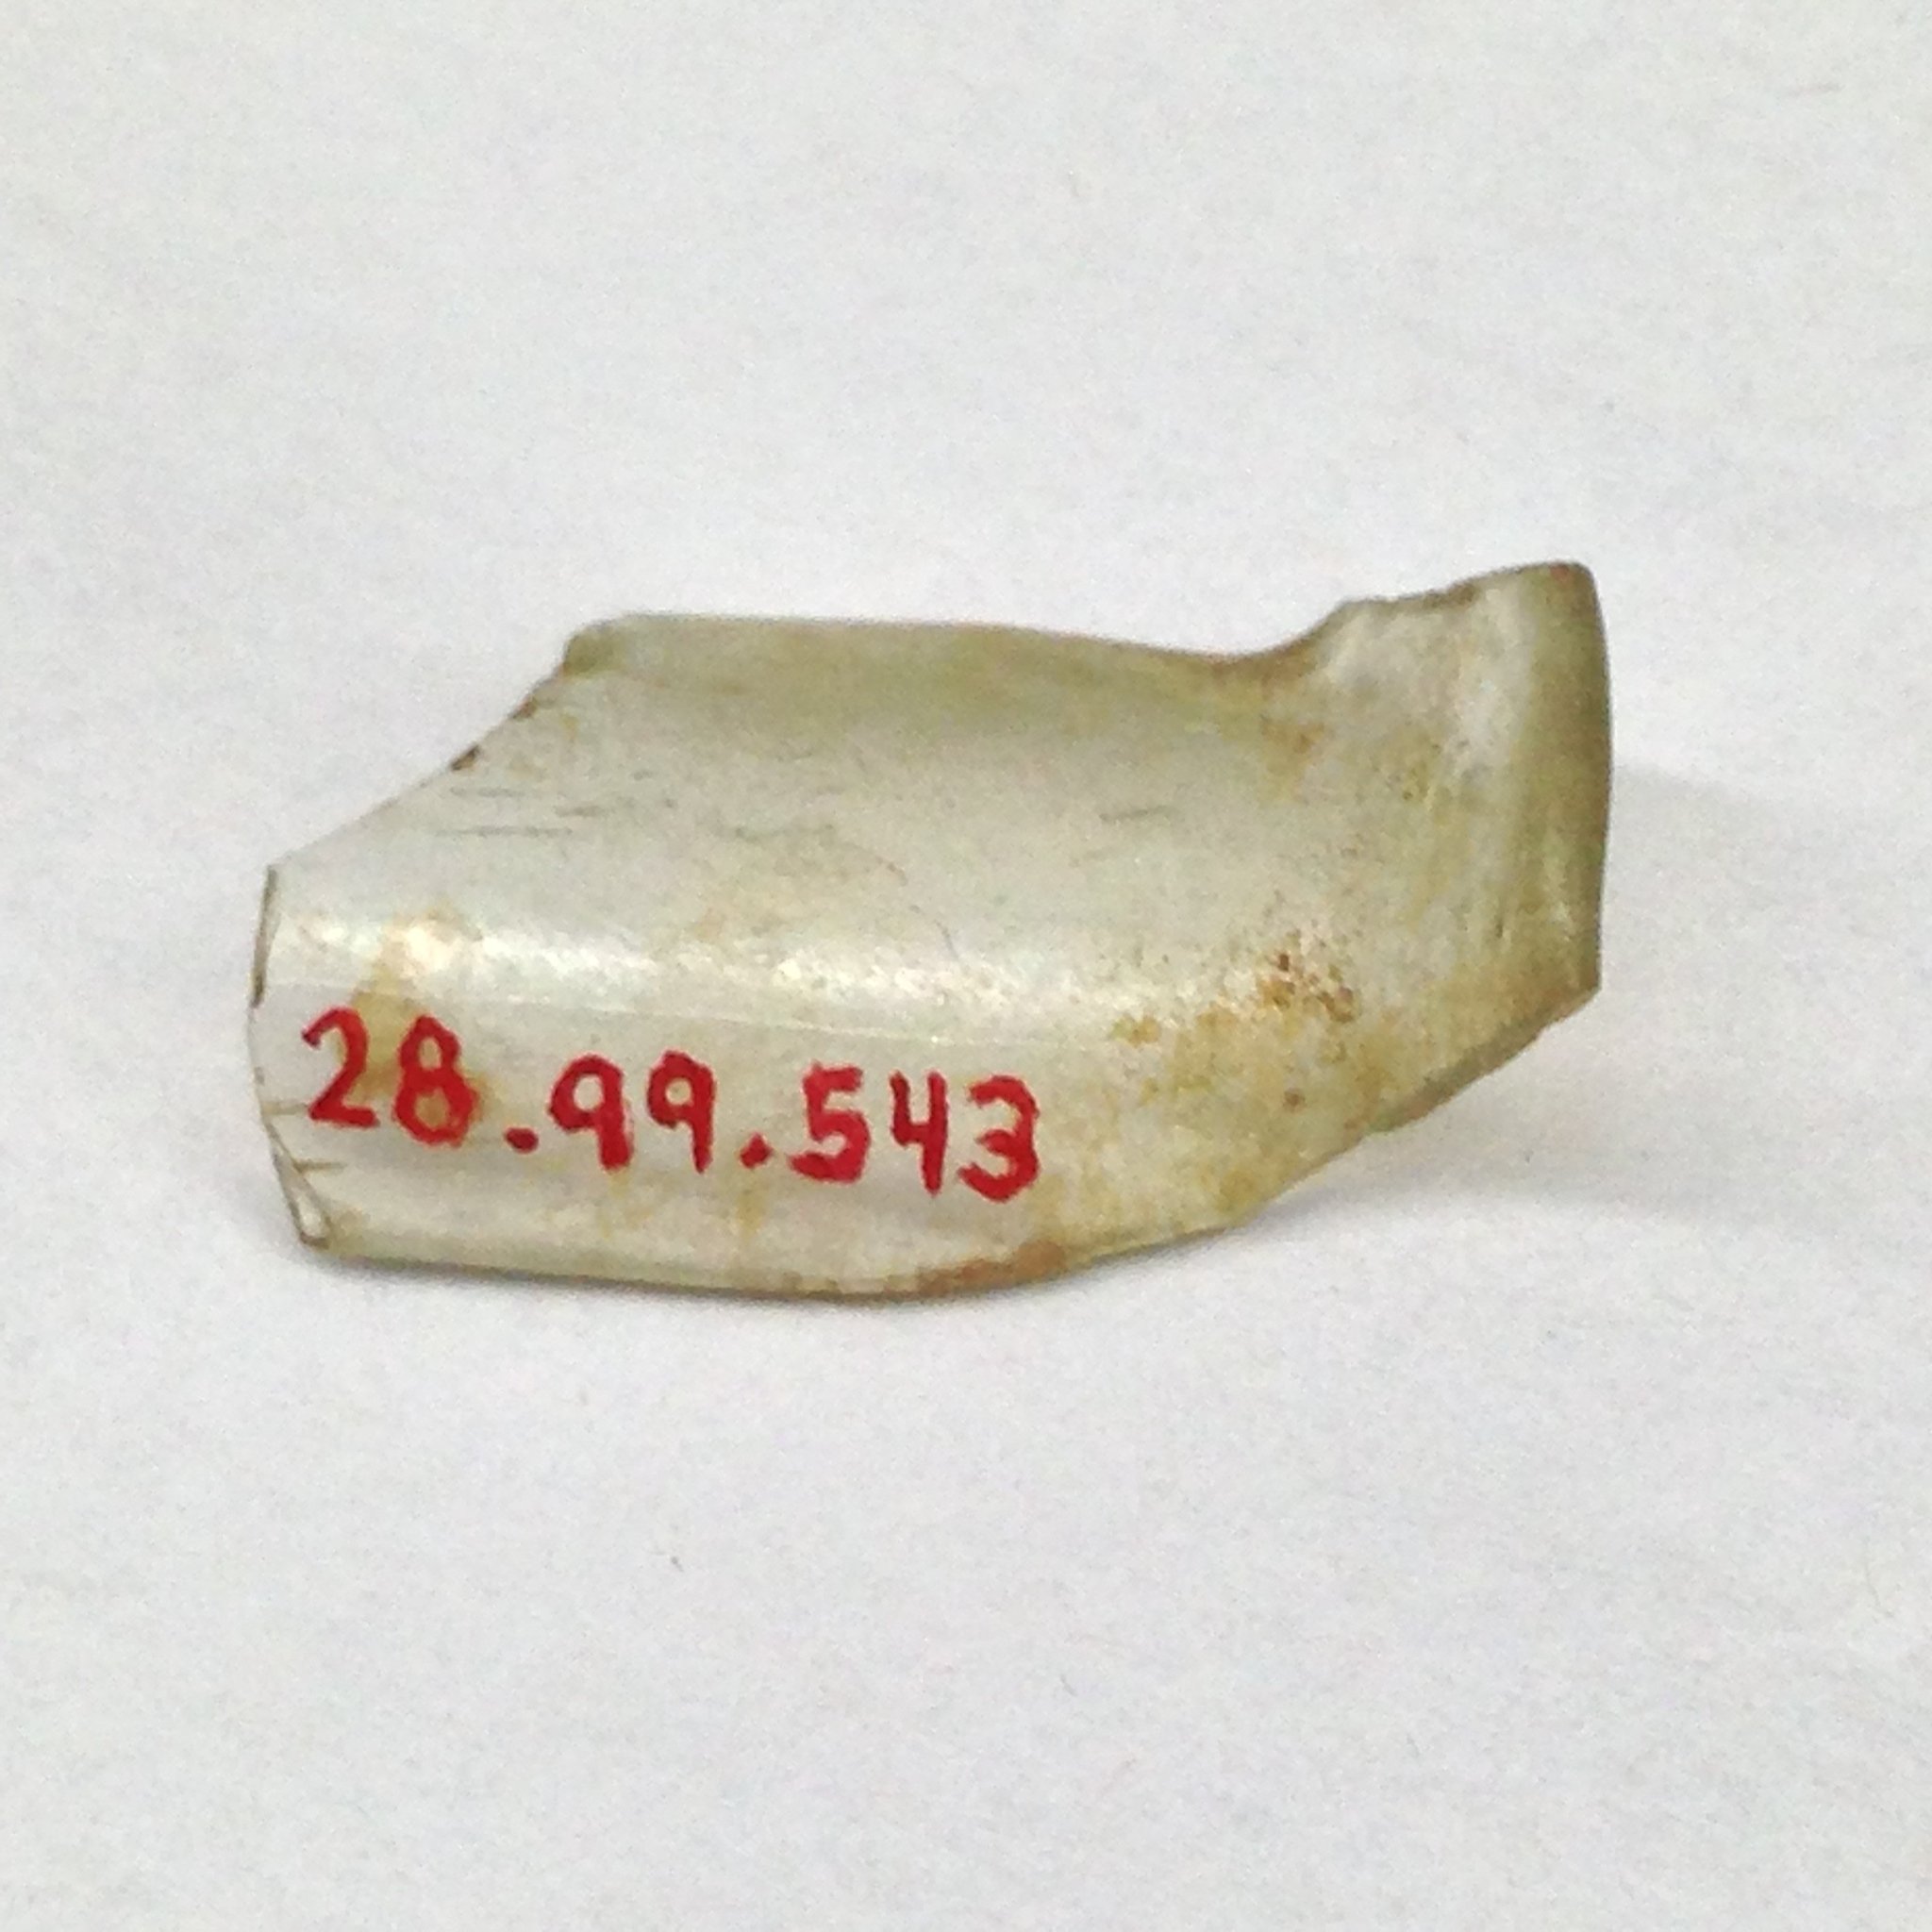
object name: fragment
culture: european or middle eastern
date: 1150-1250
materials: ceramic, glass